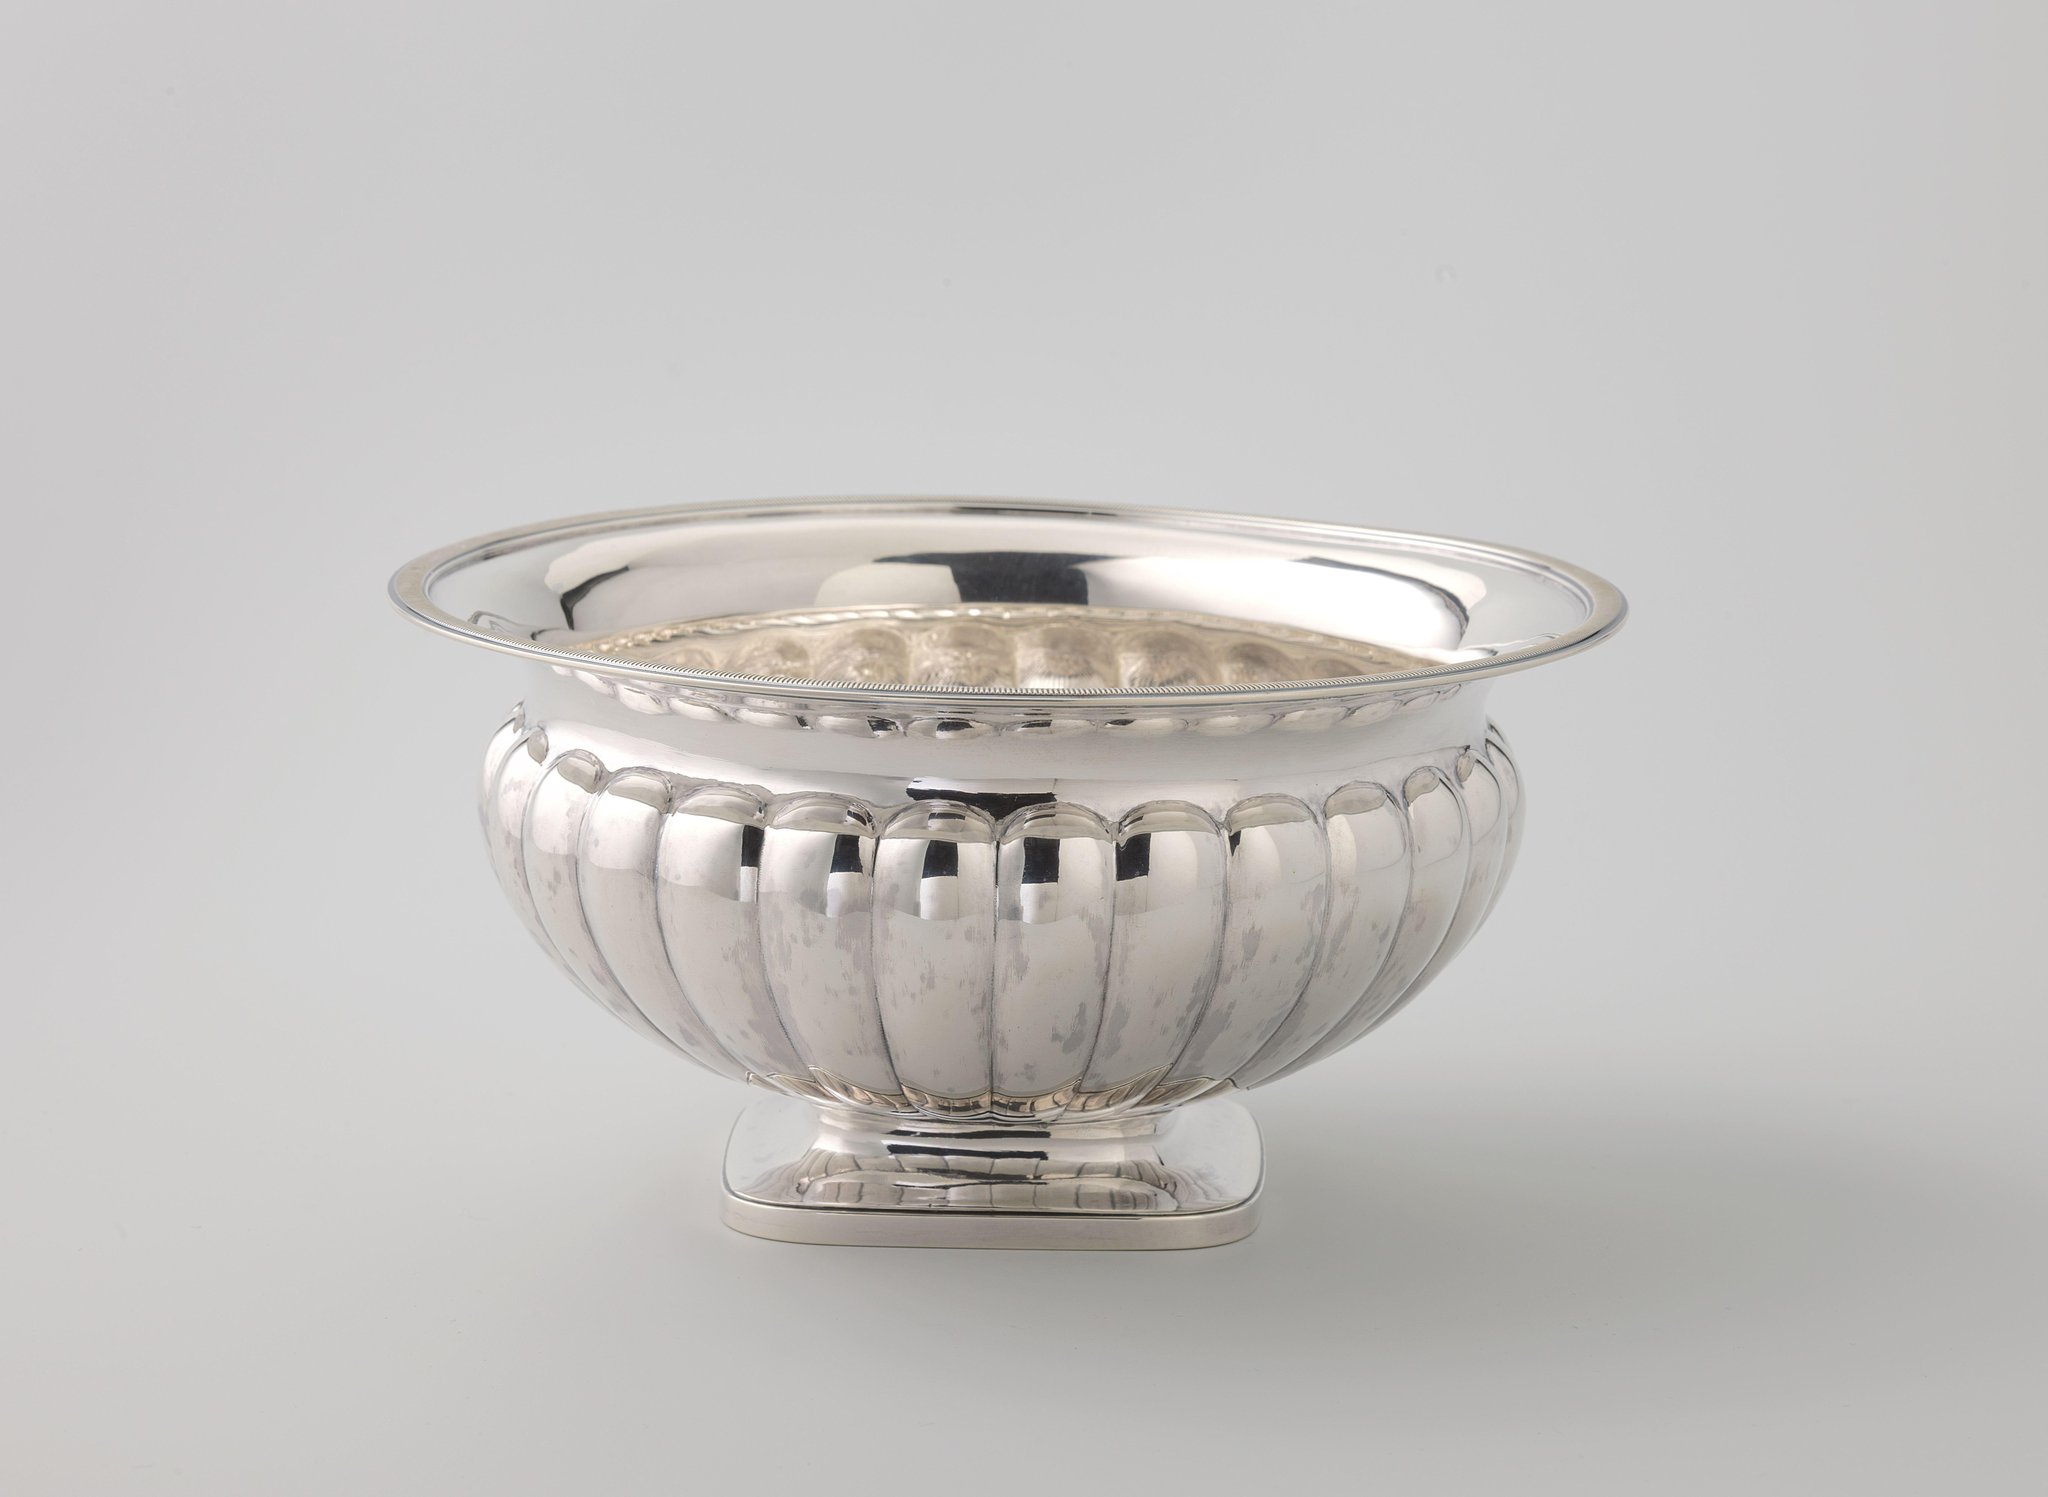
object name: slop bowl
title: Spoelkom, rond, met lobben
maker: diederik lodewijk bennewitz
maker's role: silversmith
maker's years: 1763-1826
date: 1825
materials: silver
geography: amsterdam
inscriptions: maker's mark, date letter: ‘Q’, assay office mark, alloy mark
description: De ronde, bolvormige, gelobde kom rust met een gewelfde voet op een rechte, vierkante basis met afgeronde hoeken. De kom heeft een gladde gewelfde bovenrand, die wordt bekroond door een geribde liprand.